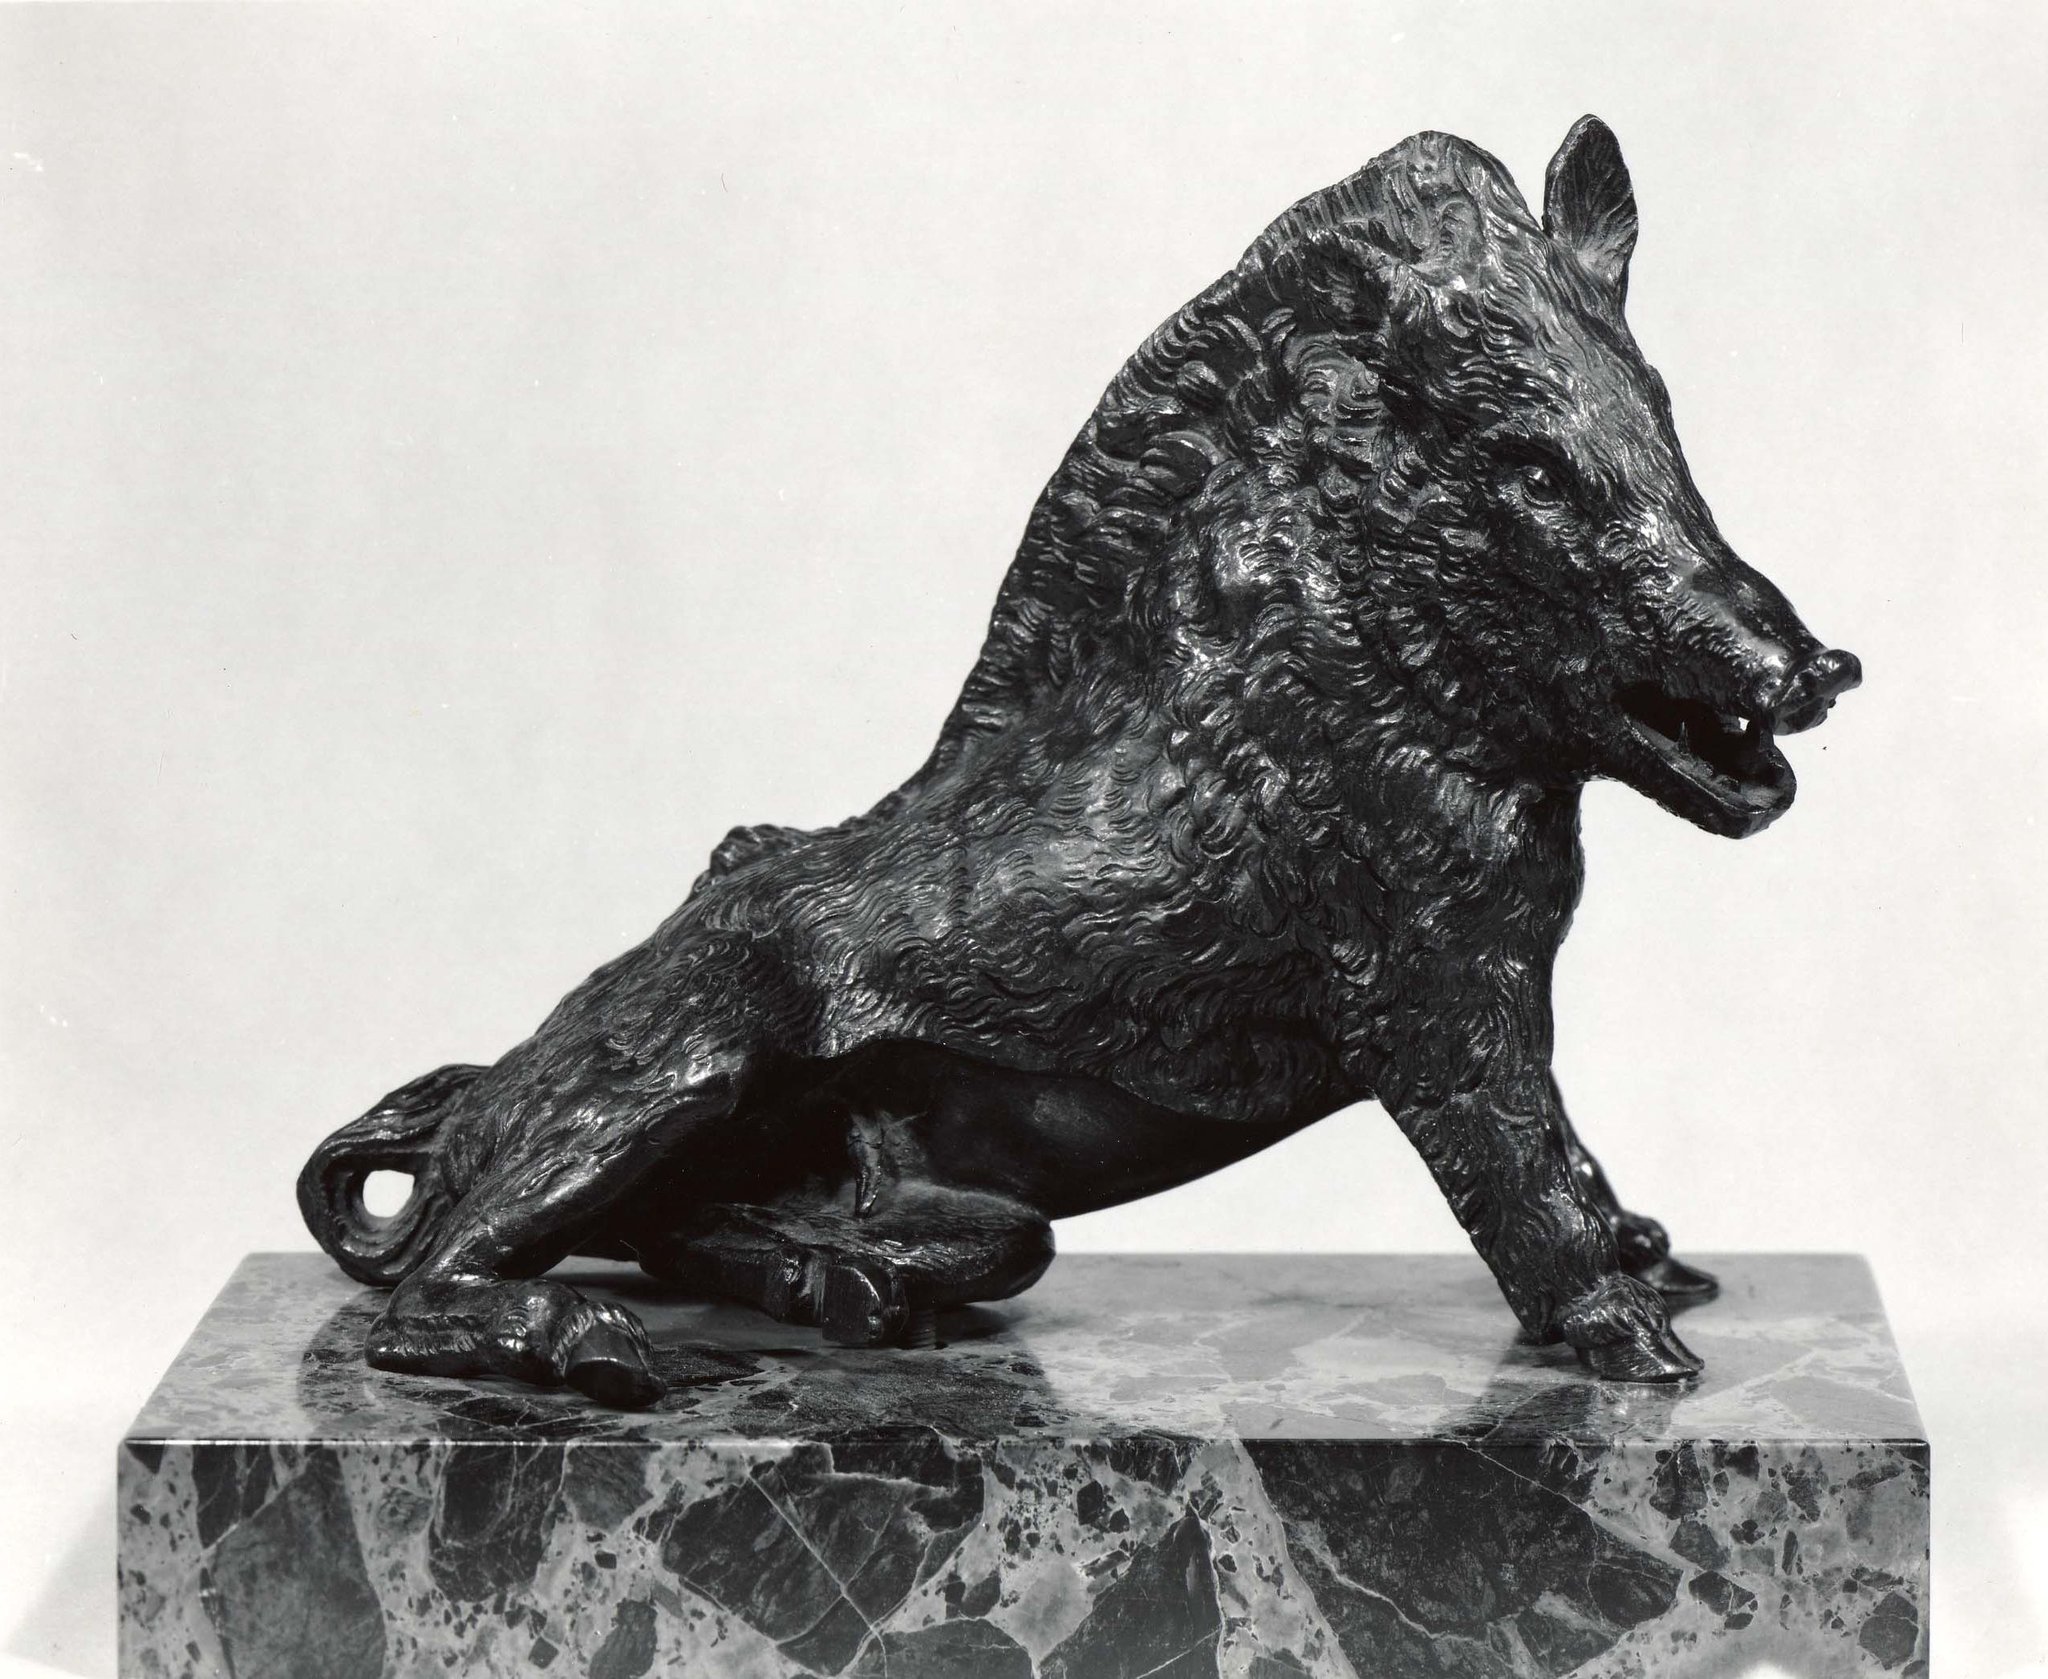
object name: sculpture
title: Crouching Boar (Il Porcellino)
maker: pietro tacca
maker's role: artist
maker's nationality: italian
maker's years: 1577-1640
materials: bronze, patina, varnish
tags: boars